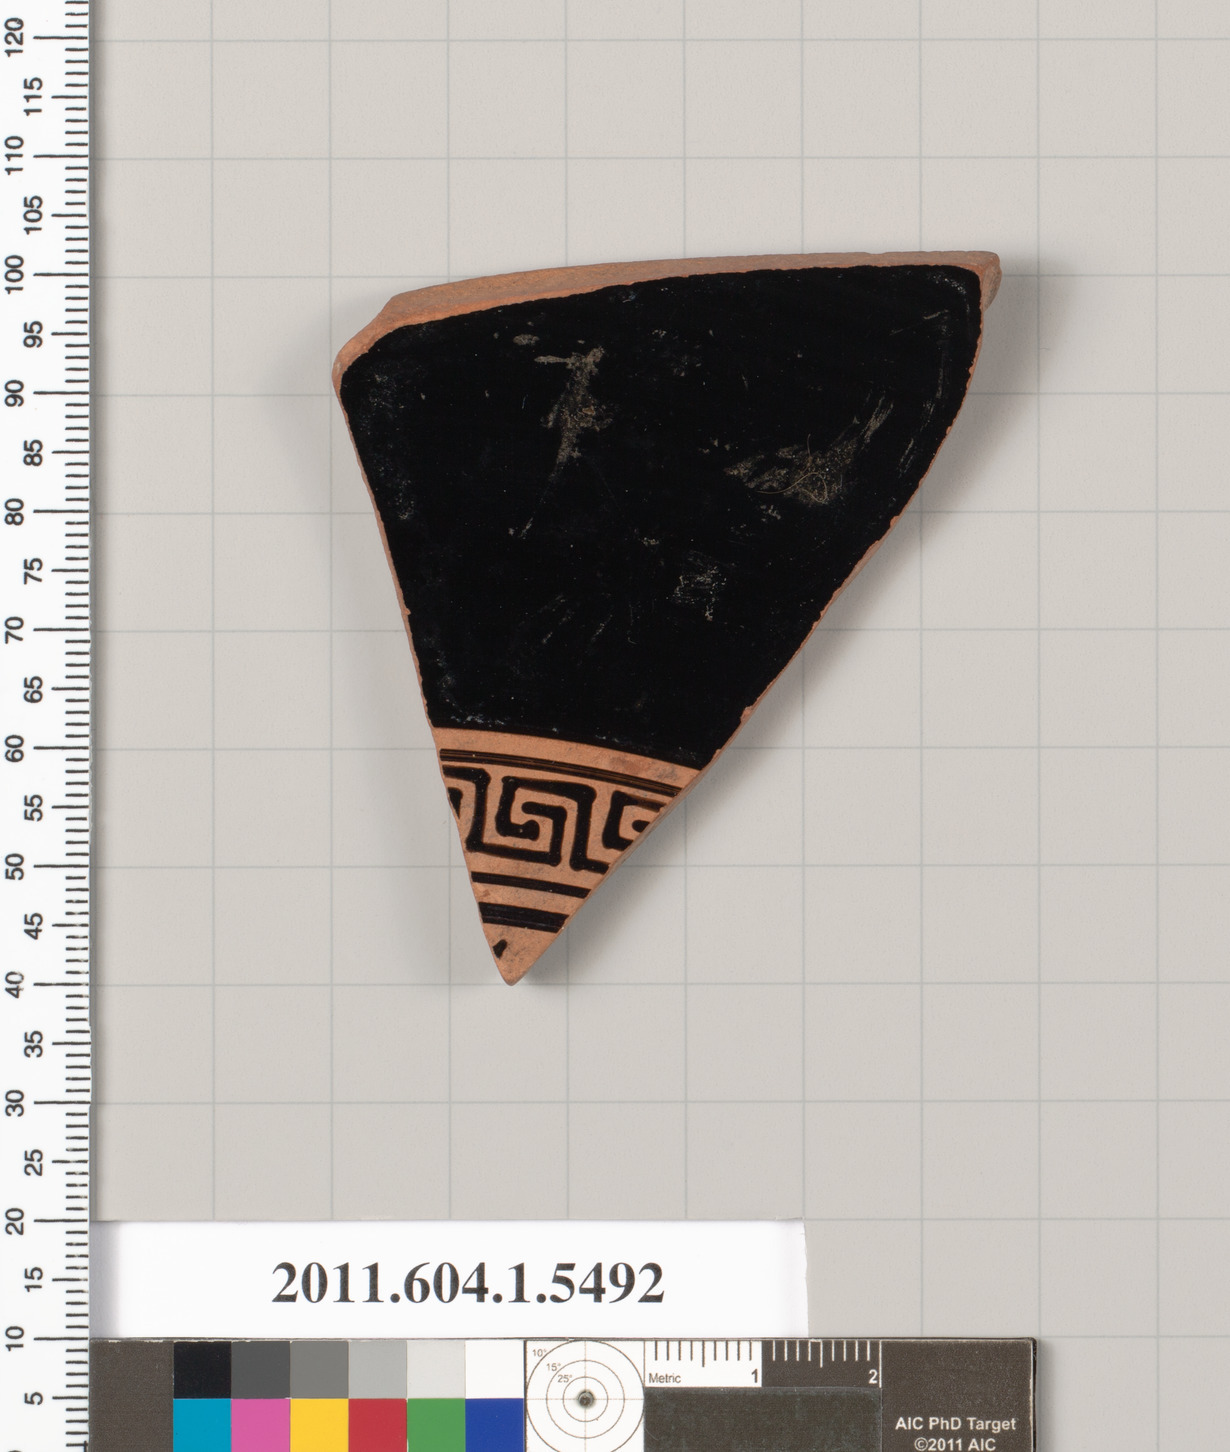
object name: kylix fragment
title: Terracotta fragment of a kylix (drinking cup)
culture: greek, attic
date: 490-480 BCE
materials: terracotta